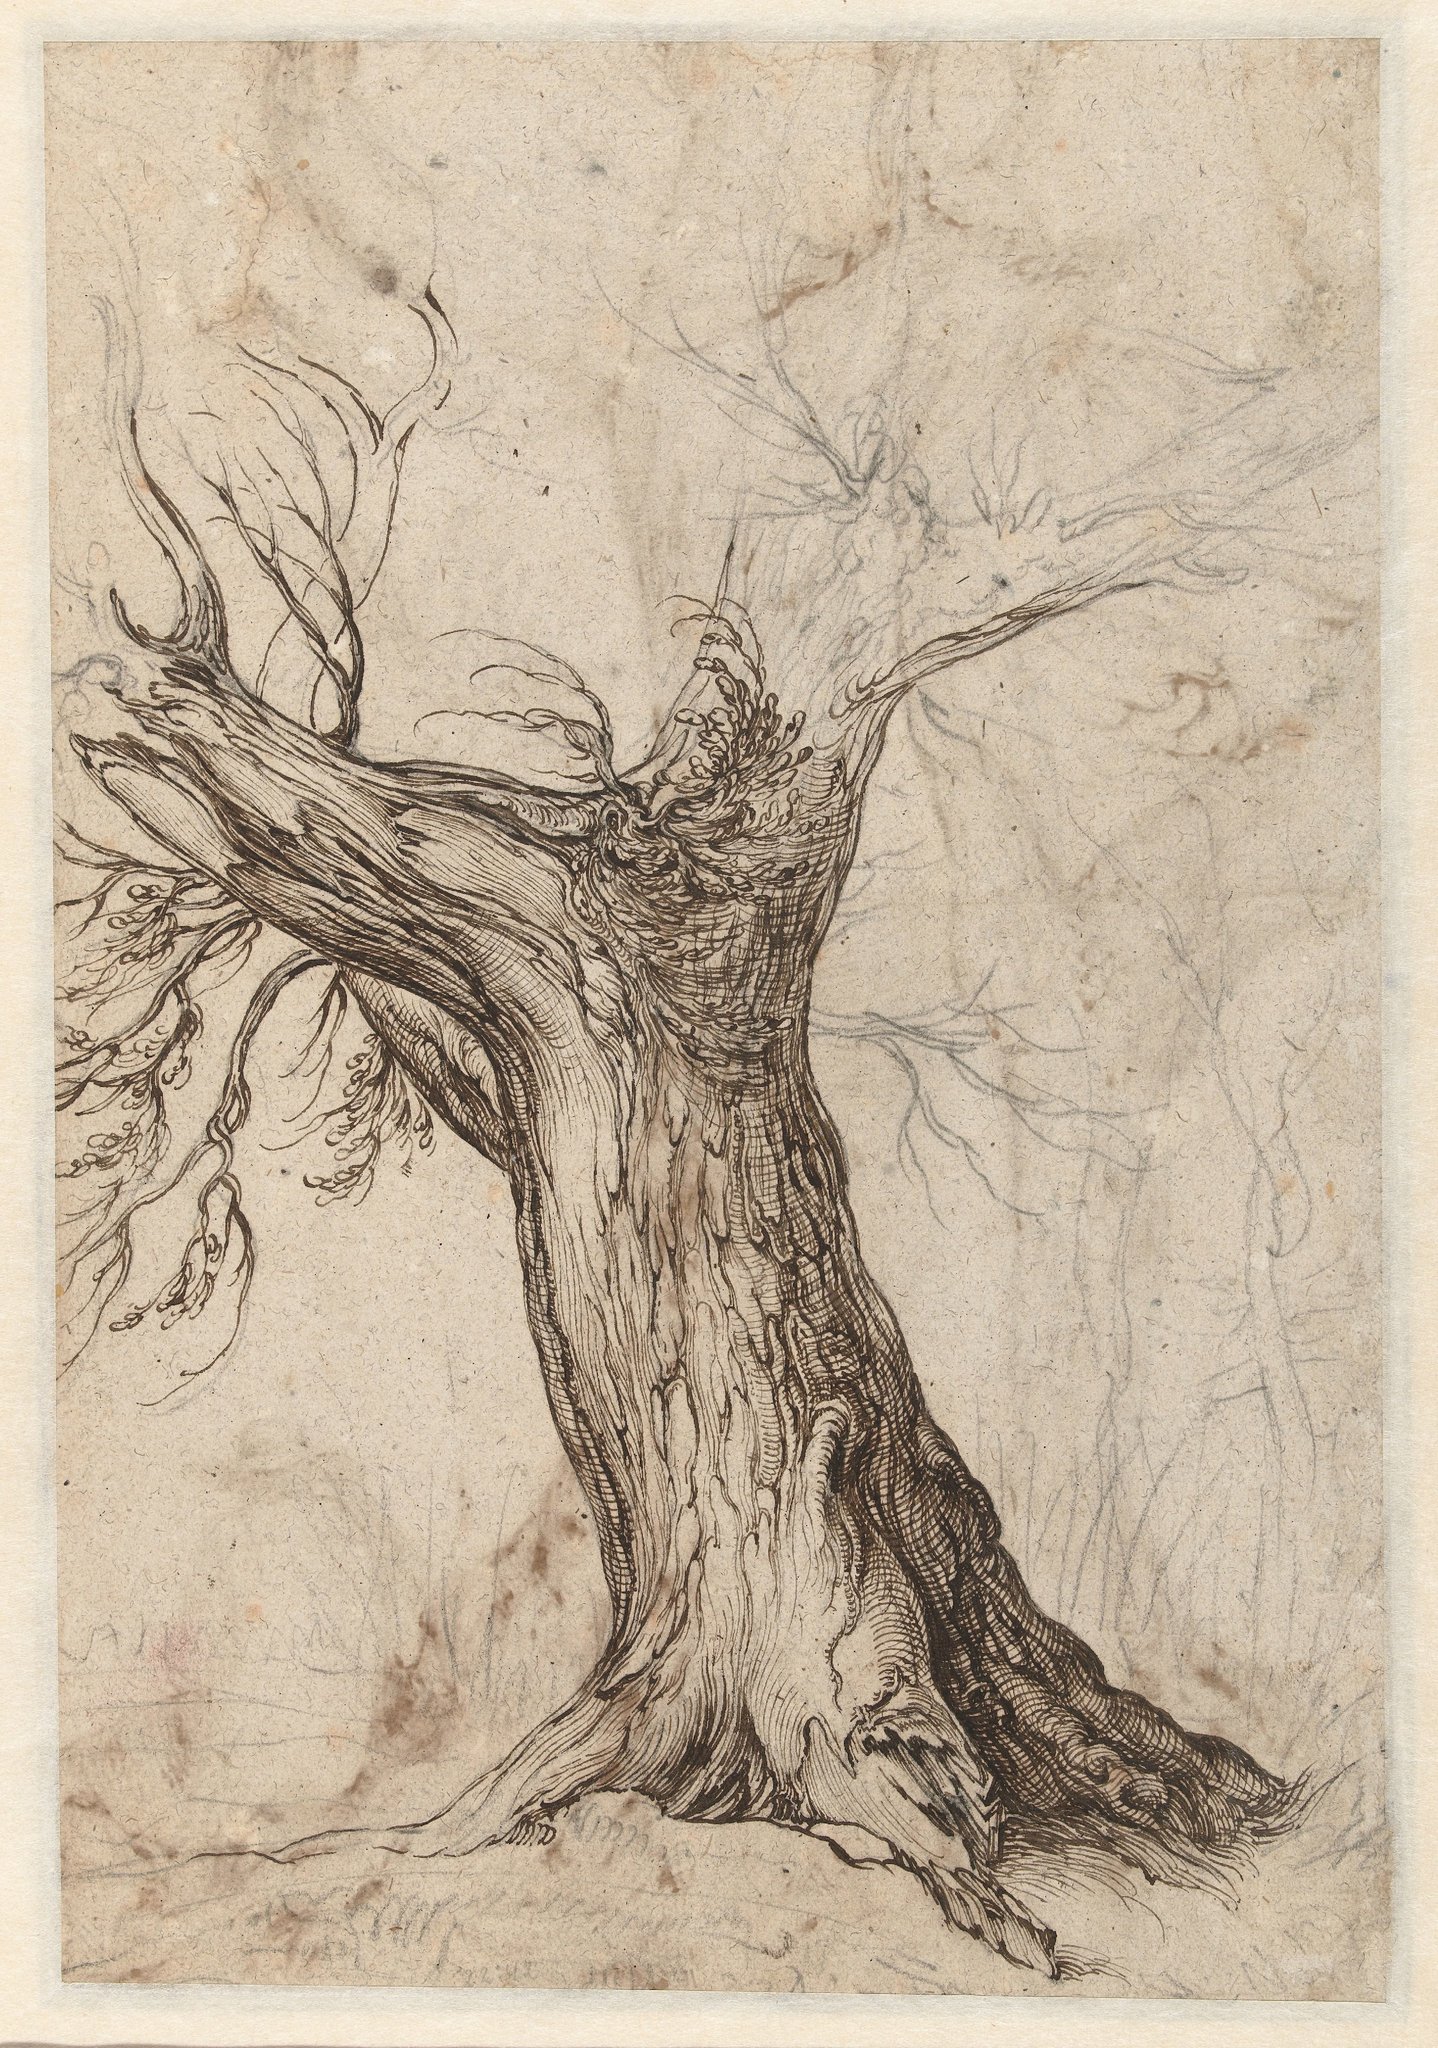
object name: drawing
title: Kastanjeboom met enkele bomen eromheen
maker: jacques de gheyn (ii)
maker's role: painter, print maker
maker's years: 1565-1629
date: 1598-1608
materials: paper, chalk, ink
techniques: pen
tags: trees: chestnut-tree